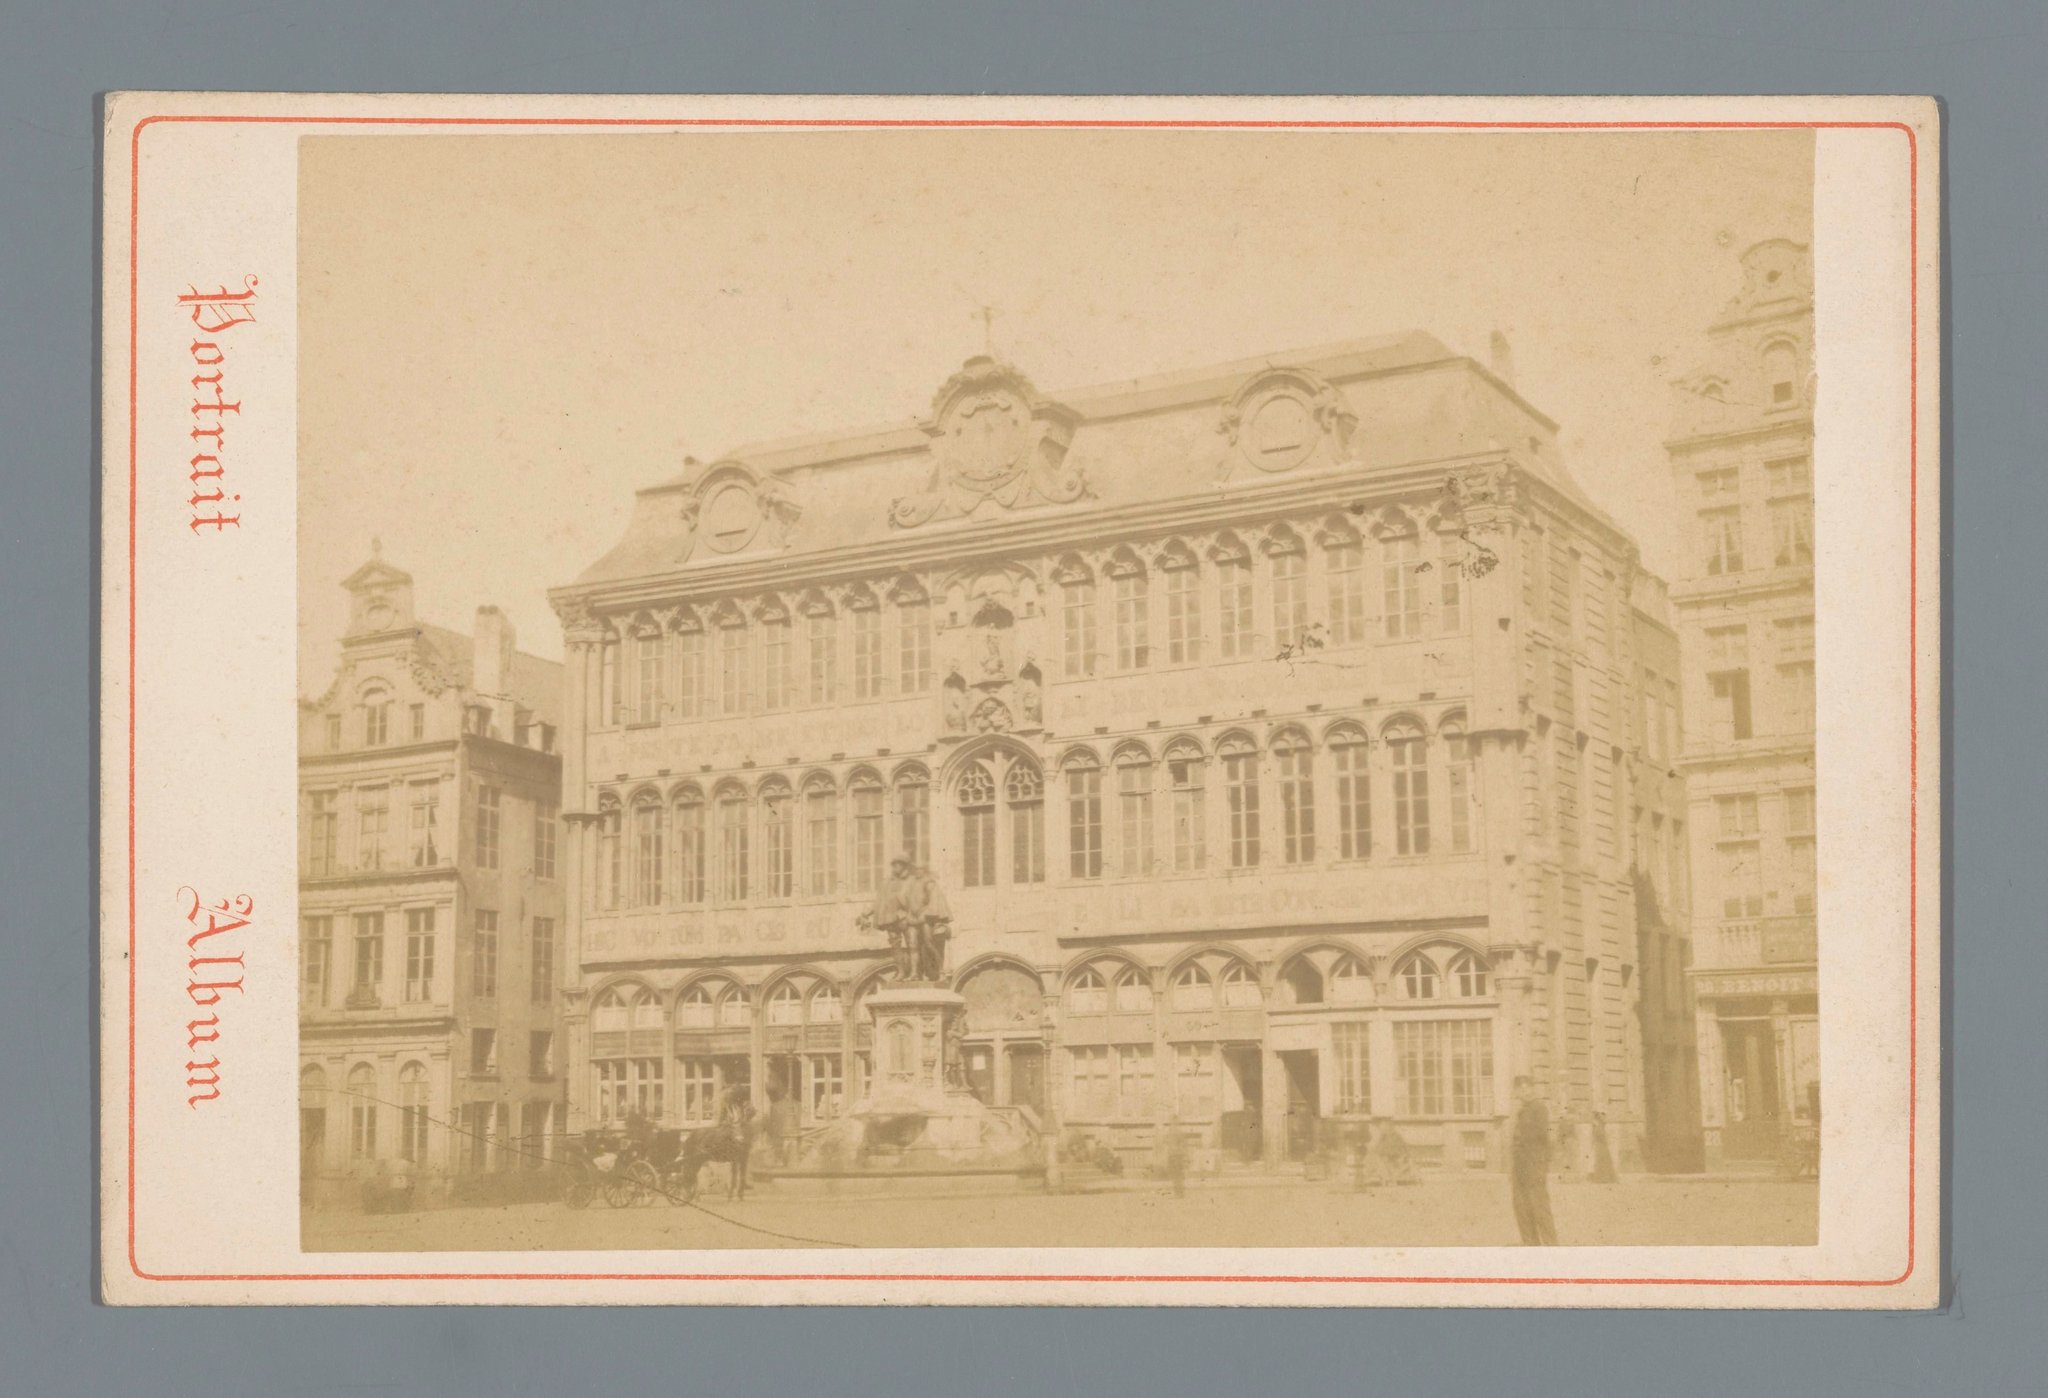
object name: cabinet photograph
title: Gezicht op het Broodhuis in Brussel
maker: Anonymous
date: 1850-1879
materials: cardboard, photographic support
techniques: albumen print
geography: grote markt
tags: city-view, and landscape with man-made constructions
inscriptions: annotation: ‘Ancienne Maison du Roi avec les Comts de Horn et d'Egmont’, annotation: ‘Brussel’, inscription: ‘Portrait Album’